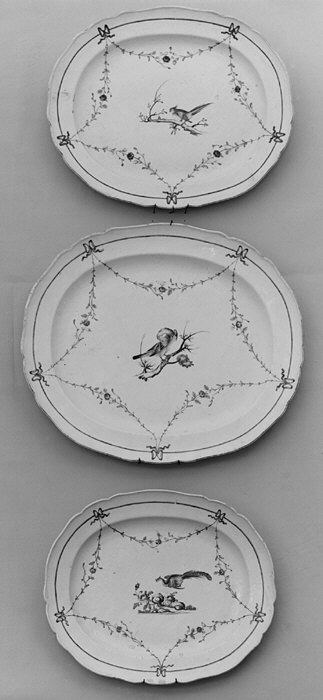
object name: platter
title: Platters (3)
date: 1770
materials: hard paste porcelain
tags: birds